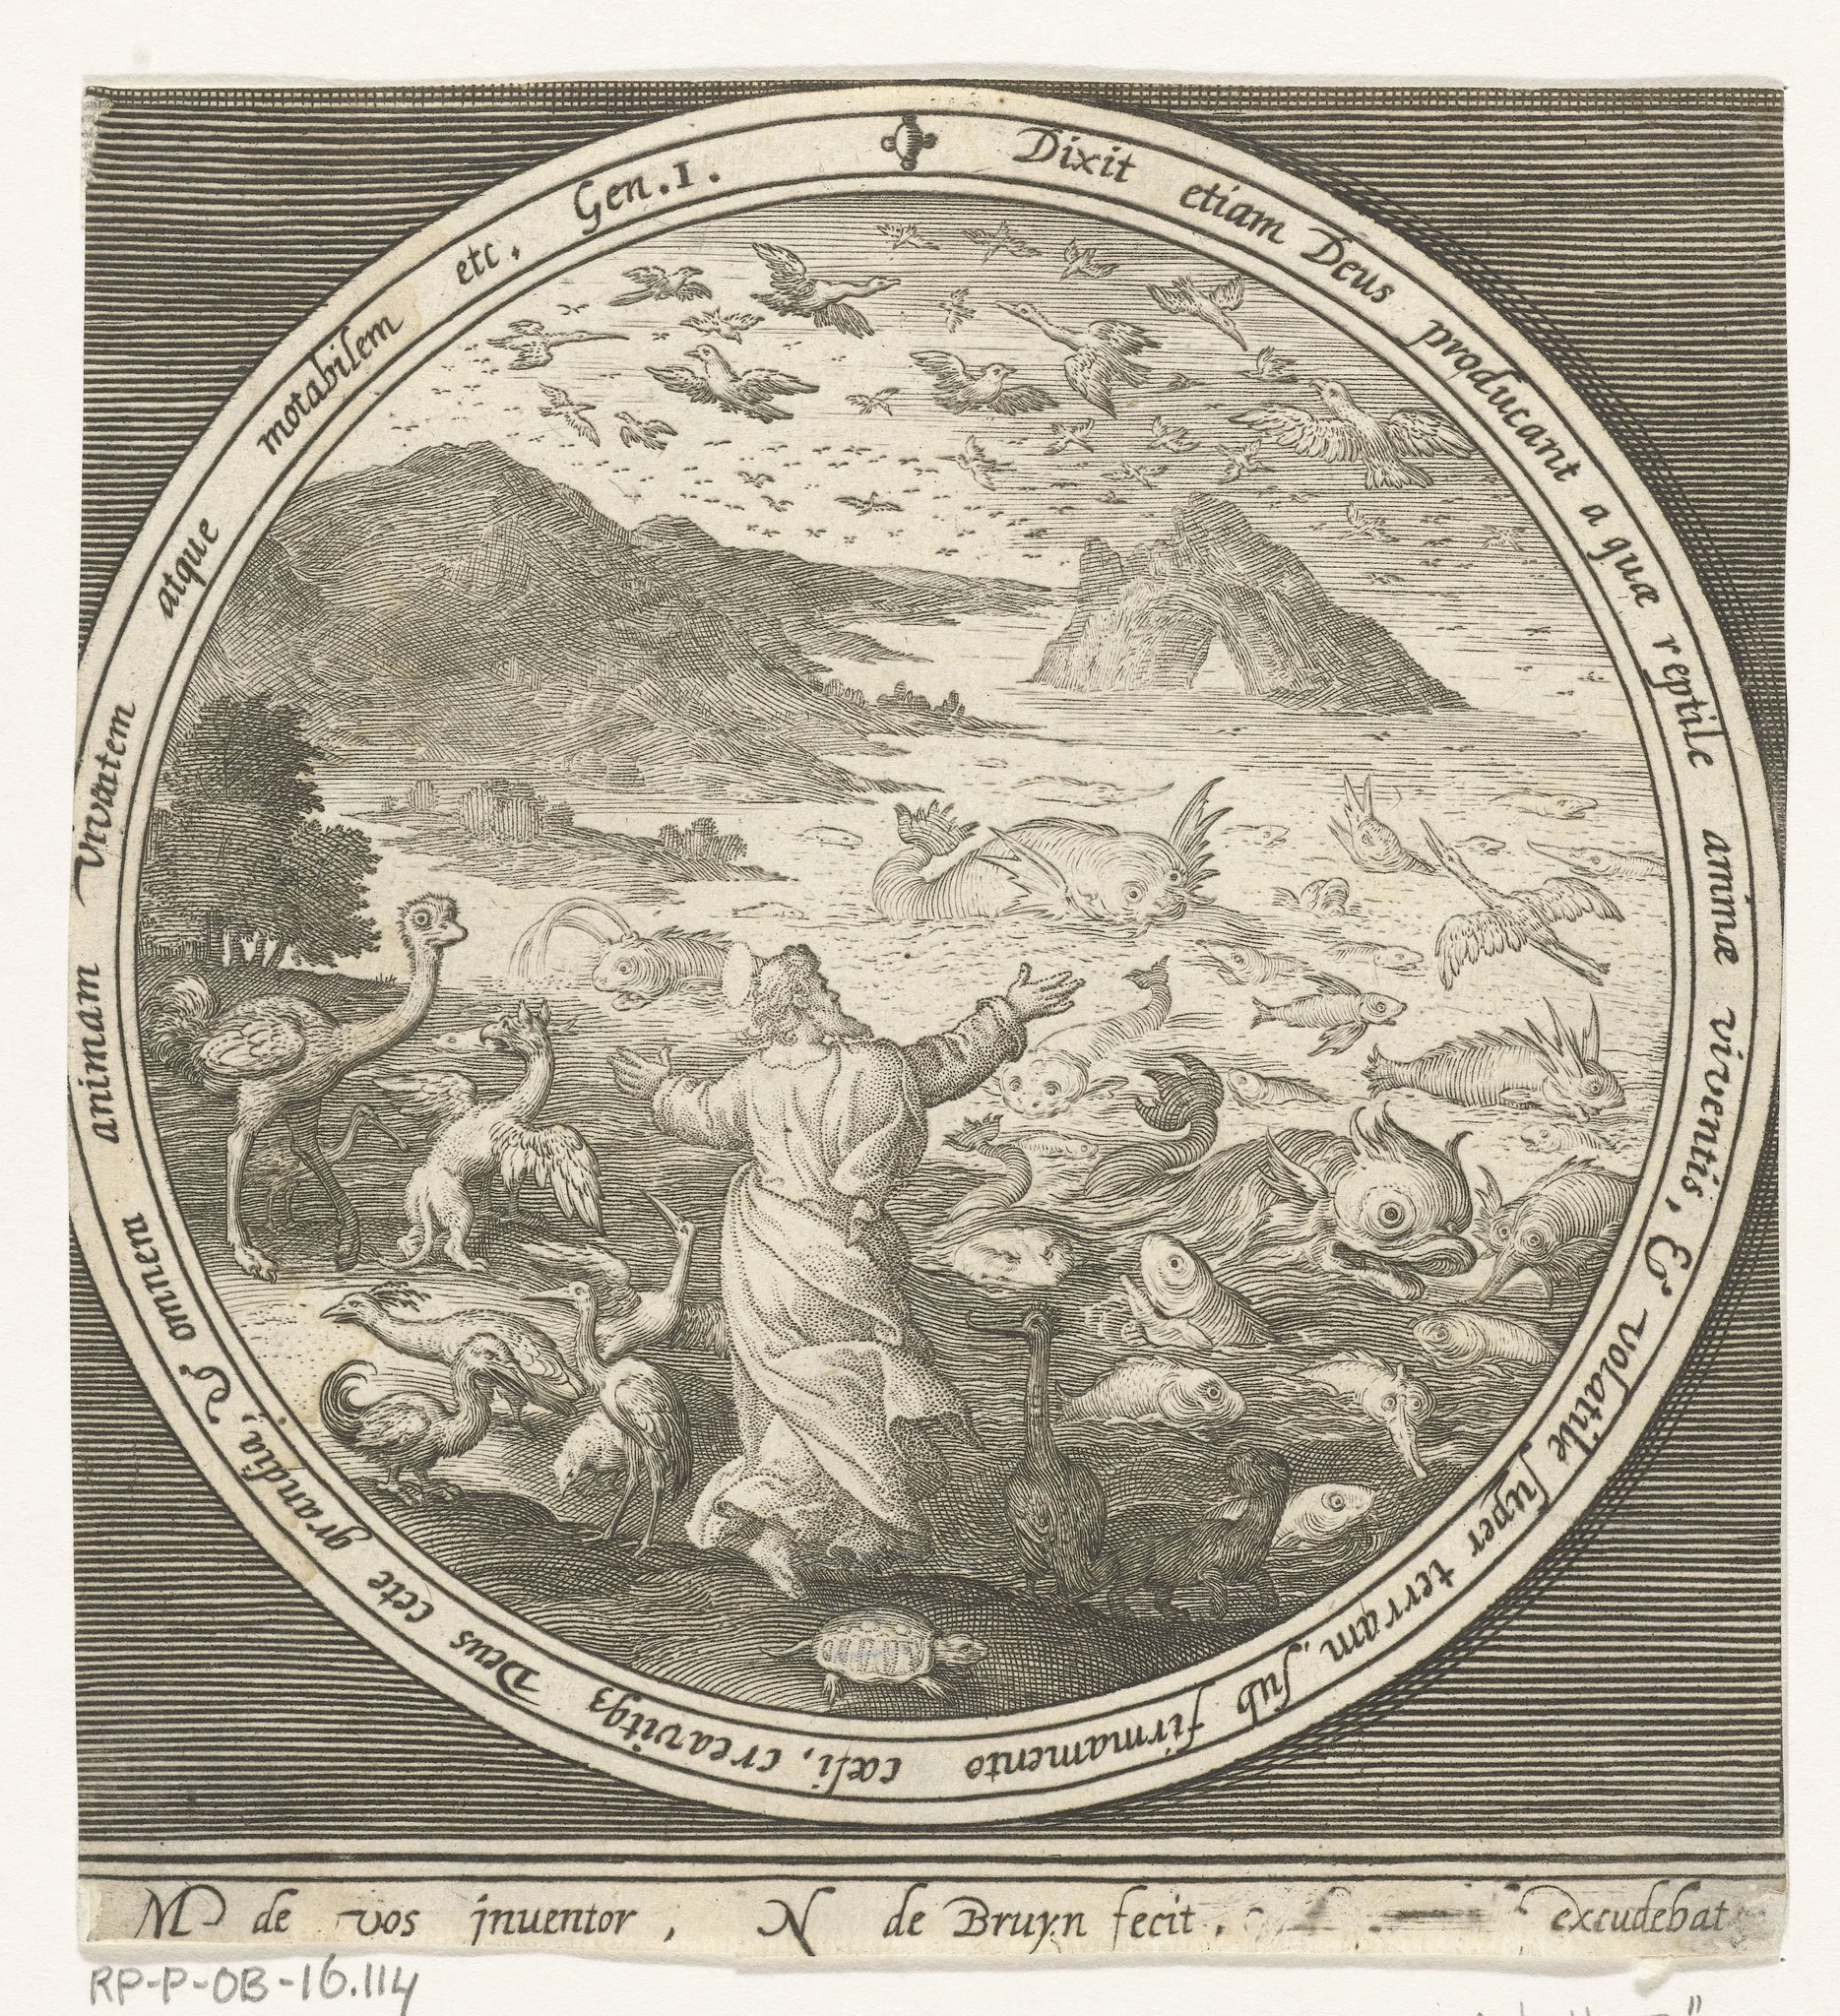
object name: print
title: Vijfde dag van schepping: God schept vissen en vogels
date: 1581-1656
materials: paper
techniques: engraving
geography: netherlands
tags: creation of birds and fishes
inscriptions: collector's mark: Lugt 2228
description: Vijfde dag van schepping: God schept vissen en vogels zodat het water wemelt van de levende wezens en langs het hemelgewelf vogels vliegen. In medaillon met als opschrift een bijbeltekst in Latijn uit Genesis 1, binnen rechthoekige omlijsting.